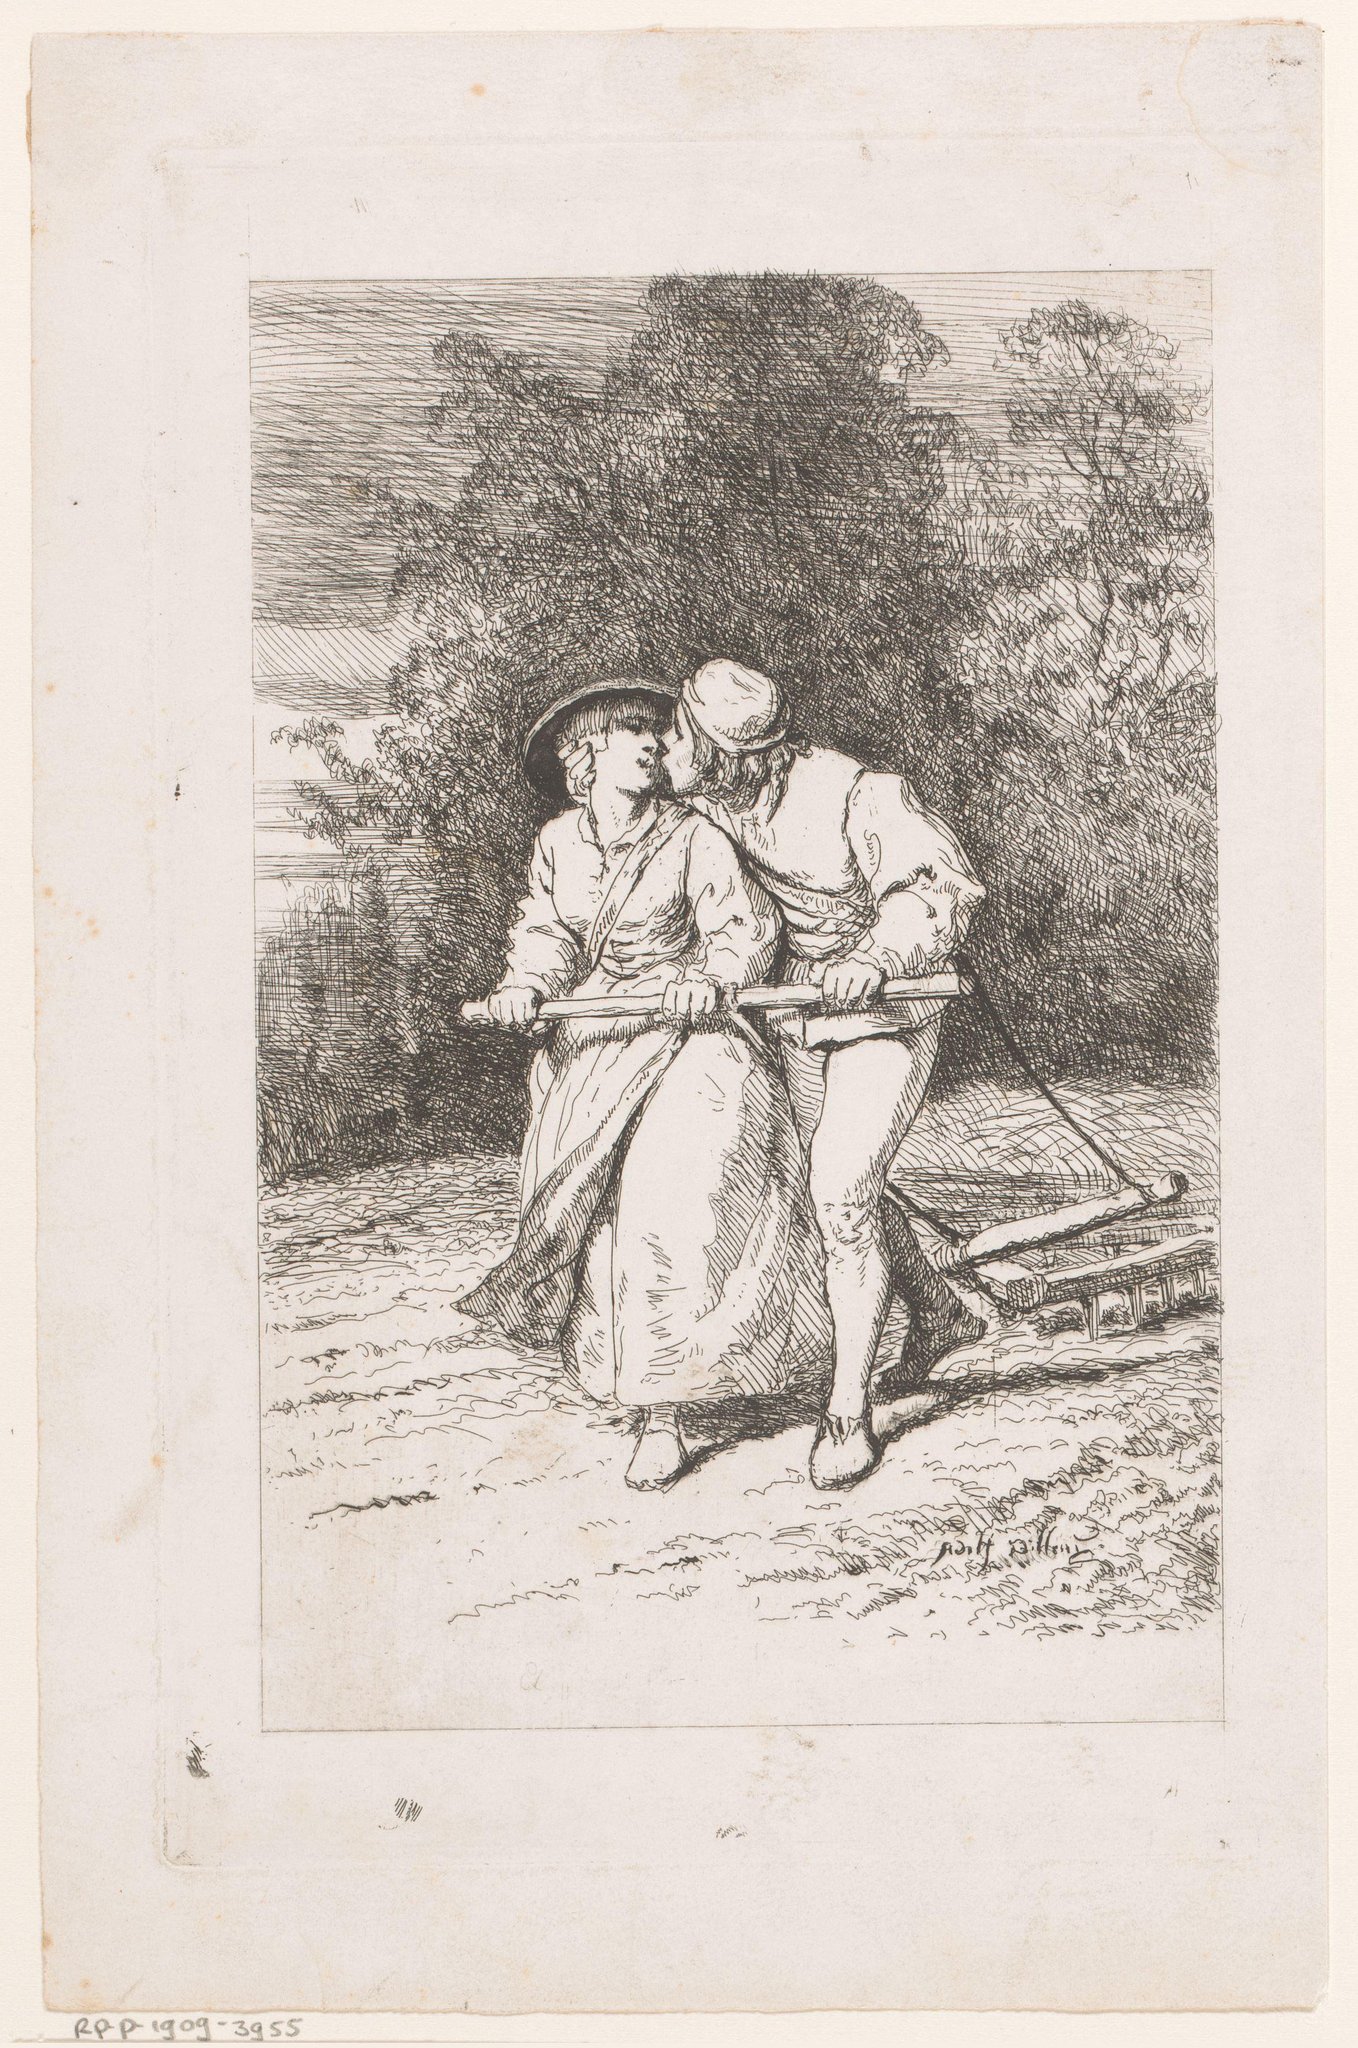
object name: book illustration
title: Jonge man en vrouw ploegen samen de grond terwijl de man de vrouw kust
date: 1868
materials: paper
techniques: etching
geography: brussels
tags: (lovers) kissing each other, ploughing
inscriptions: collector's mark: Lugt 2228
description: Prent uit: Coster, Charles Théodore Henri de. La légende d'Ulenspiegel. S.l.: Librairie Internationale, 1868.